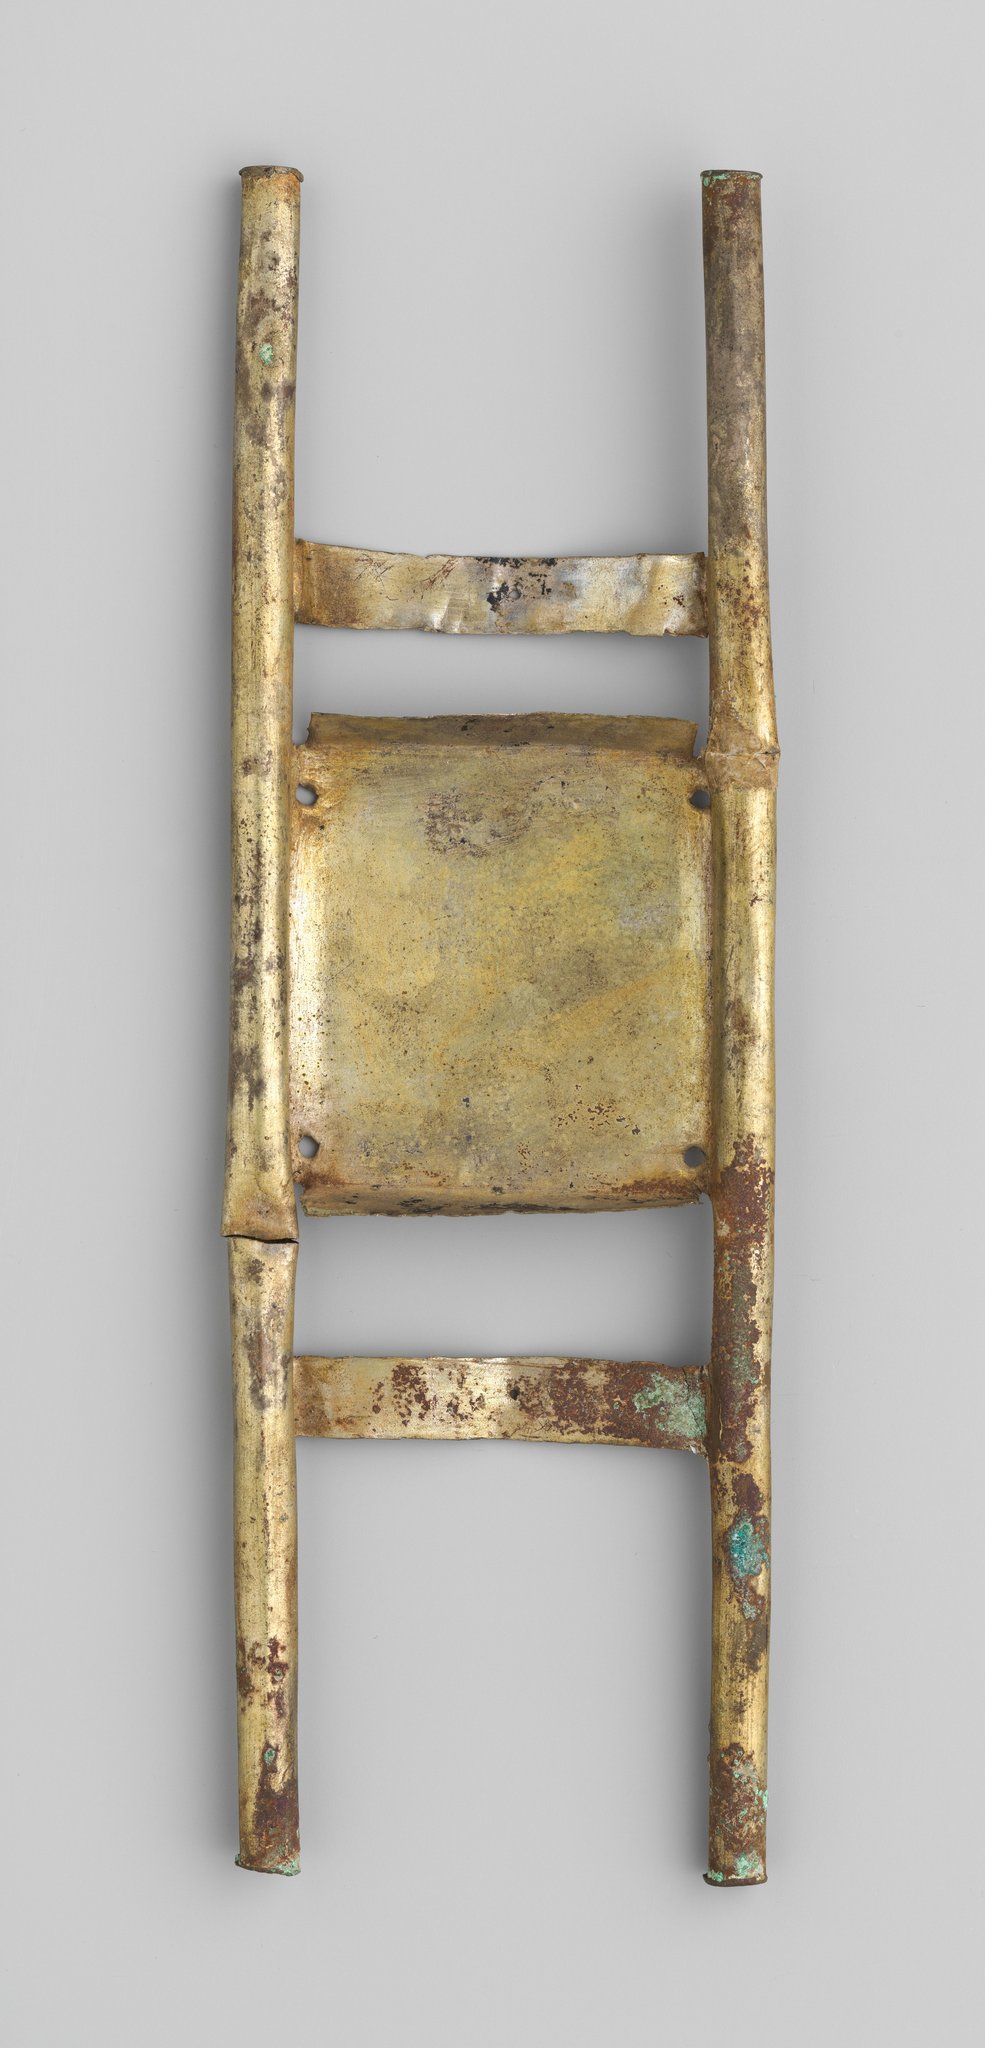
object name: litter bed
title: Miniature Litter Section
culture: chancay or chimú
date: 1001-1500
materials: gilt, silver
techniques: hammering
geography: peru